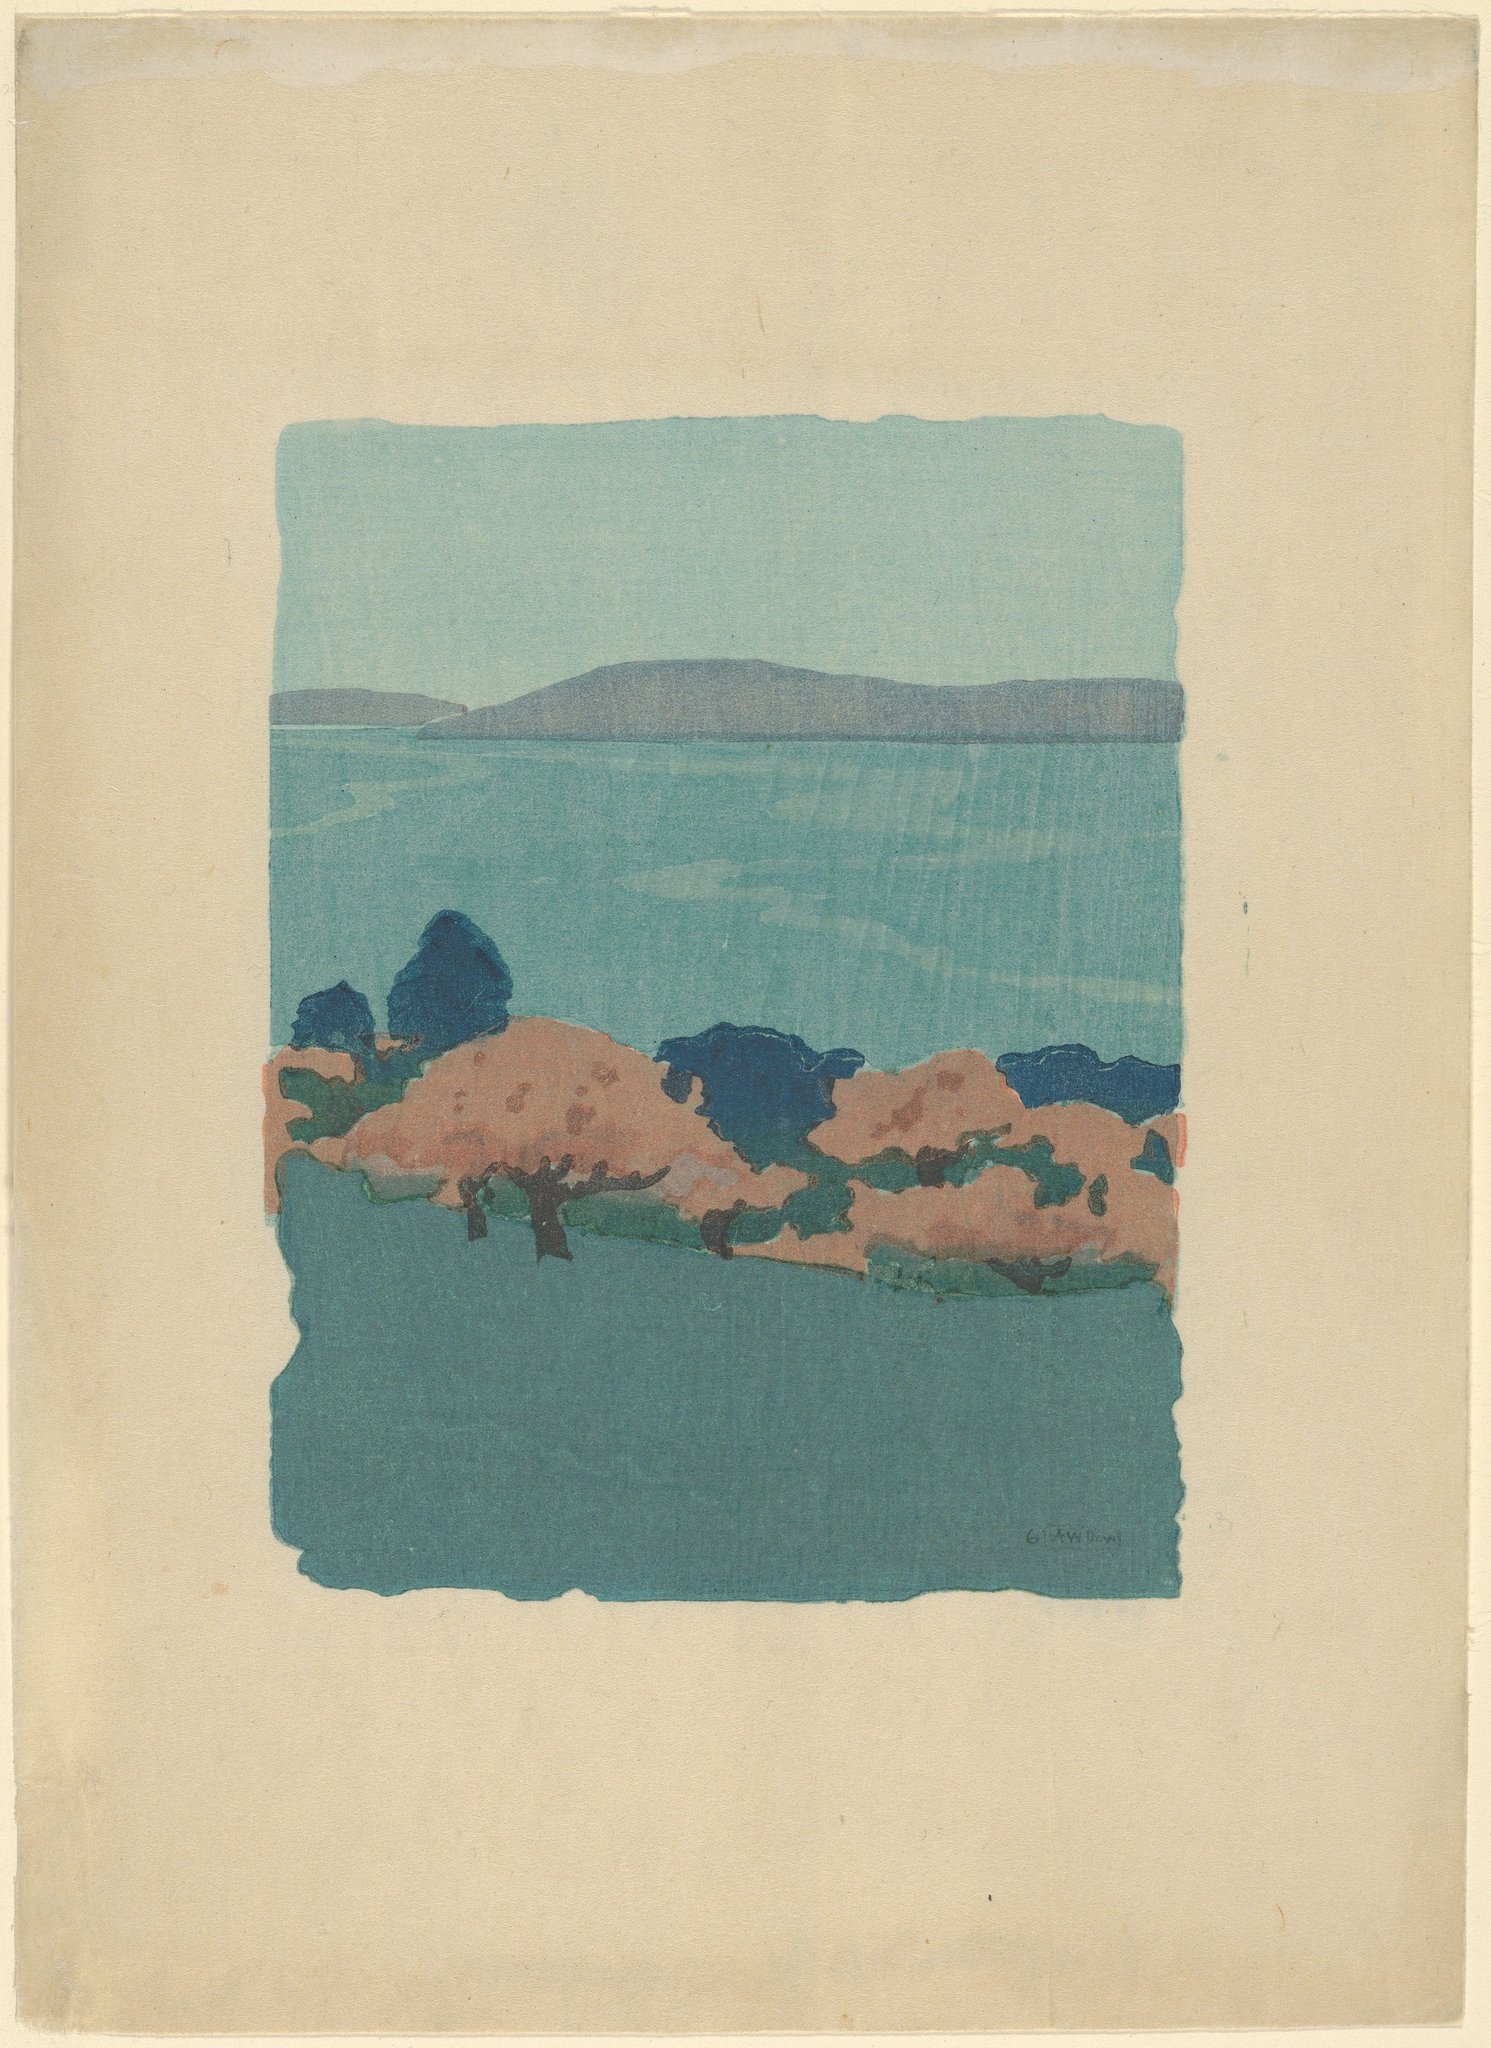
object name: print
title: Harbor and Orchard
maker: arthur wesley dow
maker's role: artist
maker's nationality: american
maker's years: 1857-1922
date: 1902-1908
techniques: woodcut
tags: mountains,landscapes